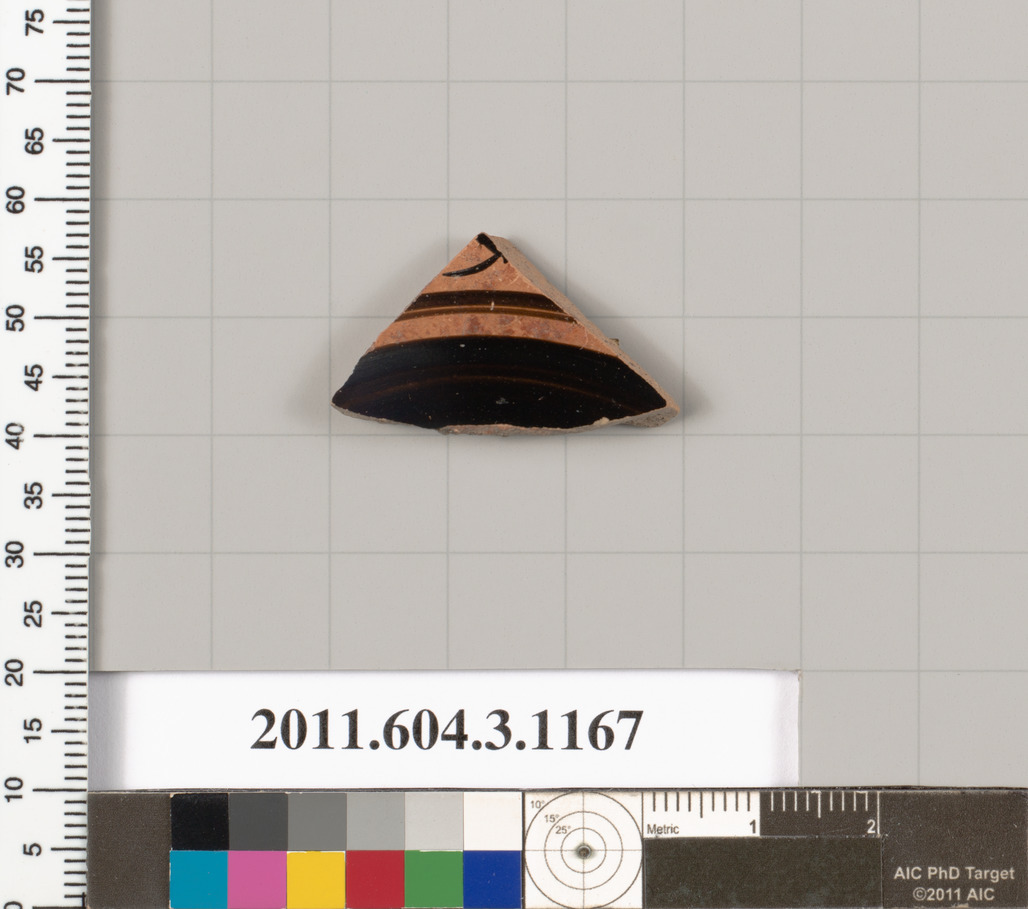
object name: mastoid or kyathos fragment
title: Terracotta fragment of a mastoid (drinking cup with narrow base) or a kyathos (cup-shaped ladle)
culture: greek, attic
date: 534-468 BCE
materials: terracotta